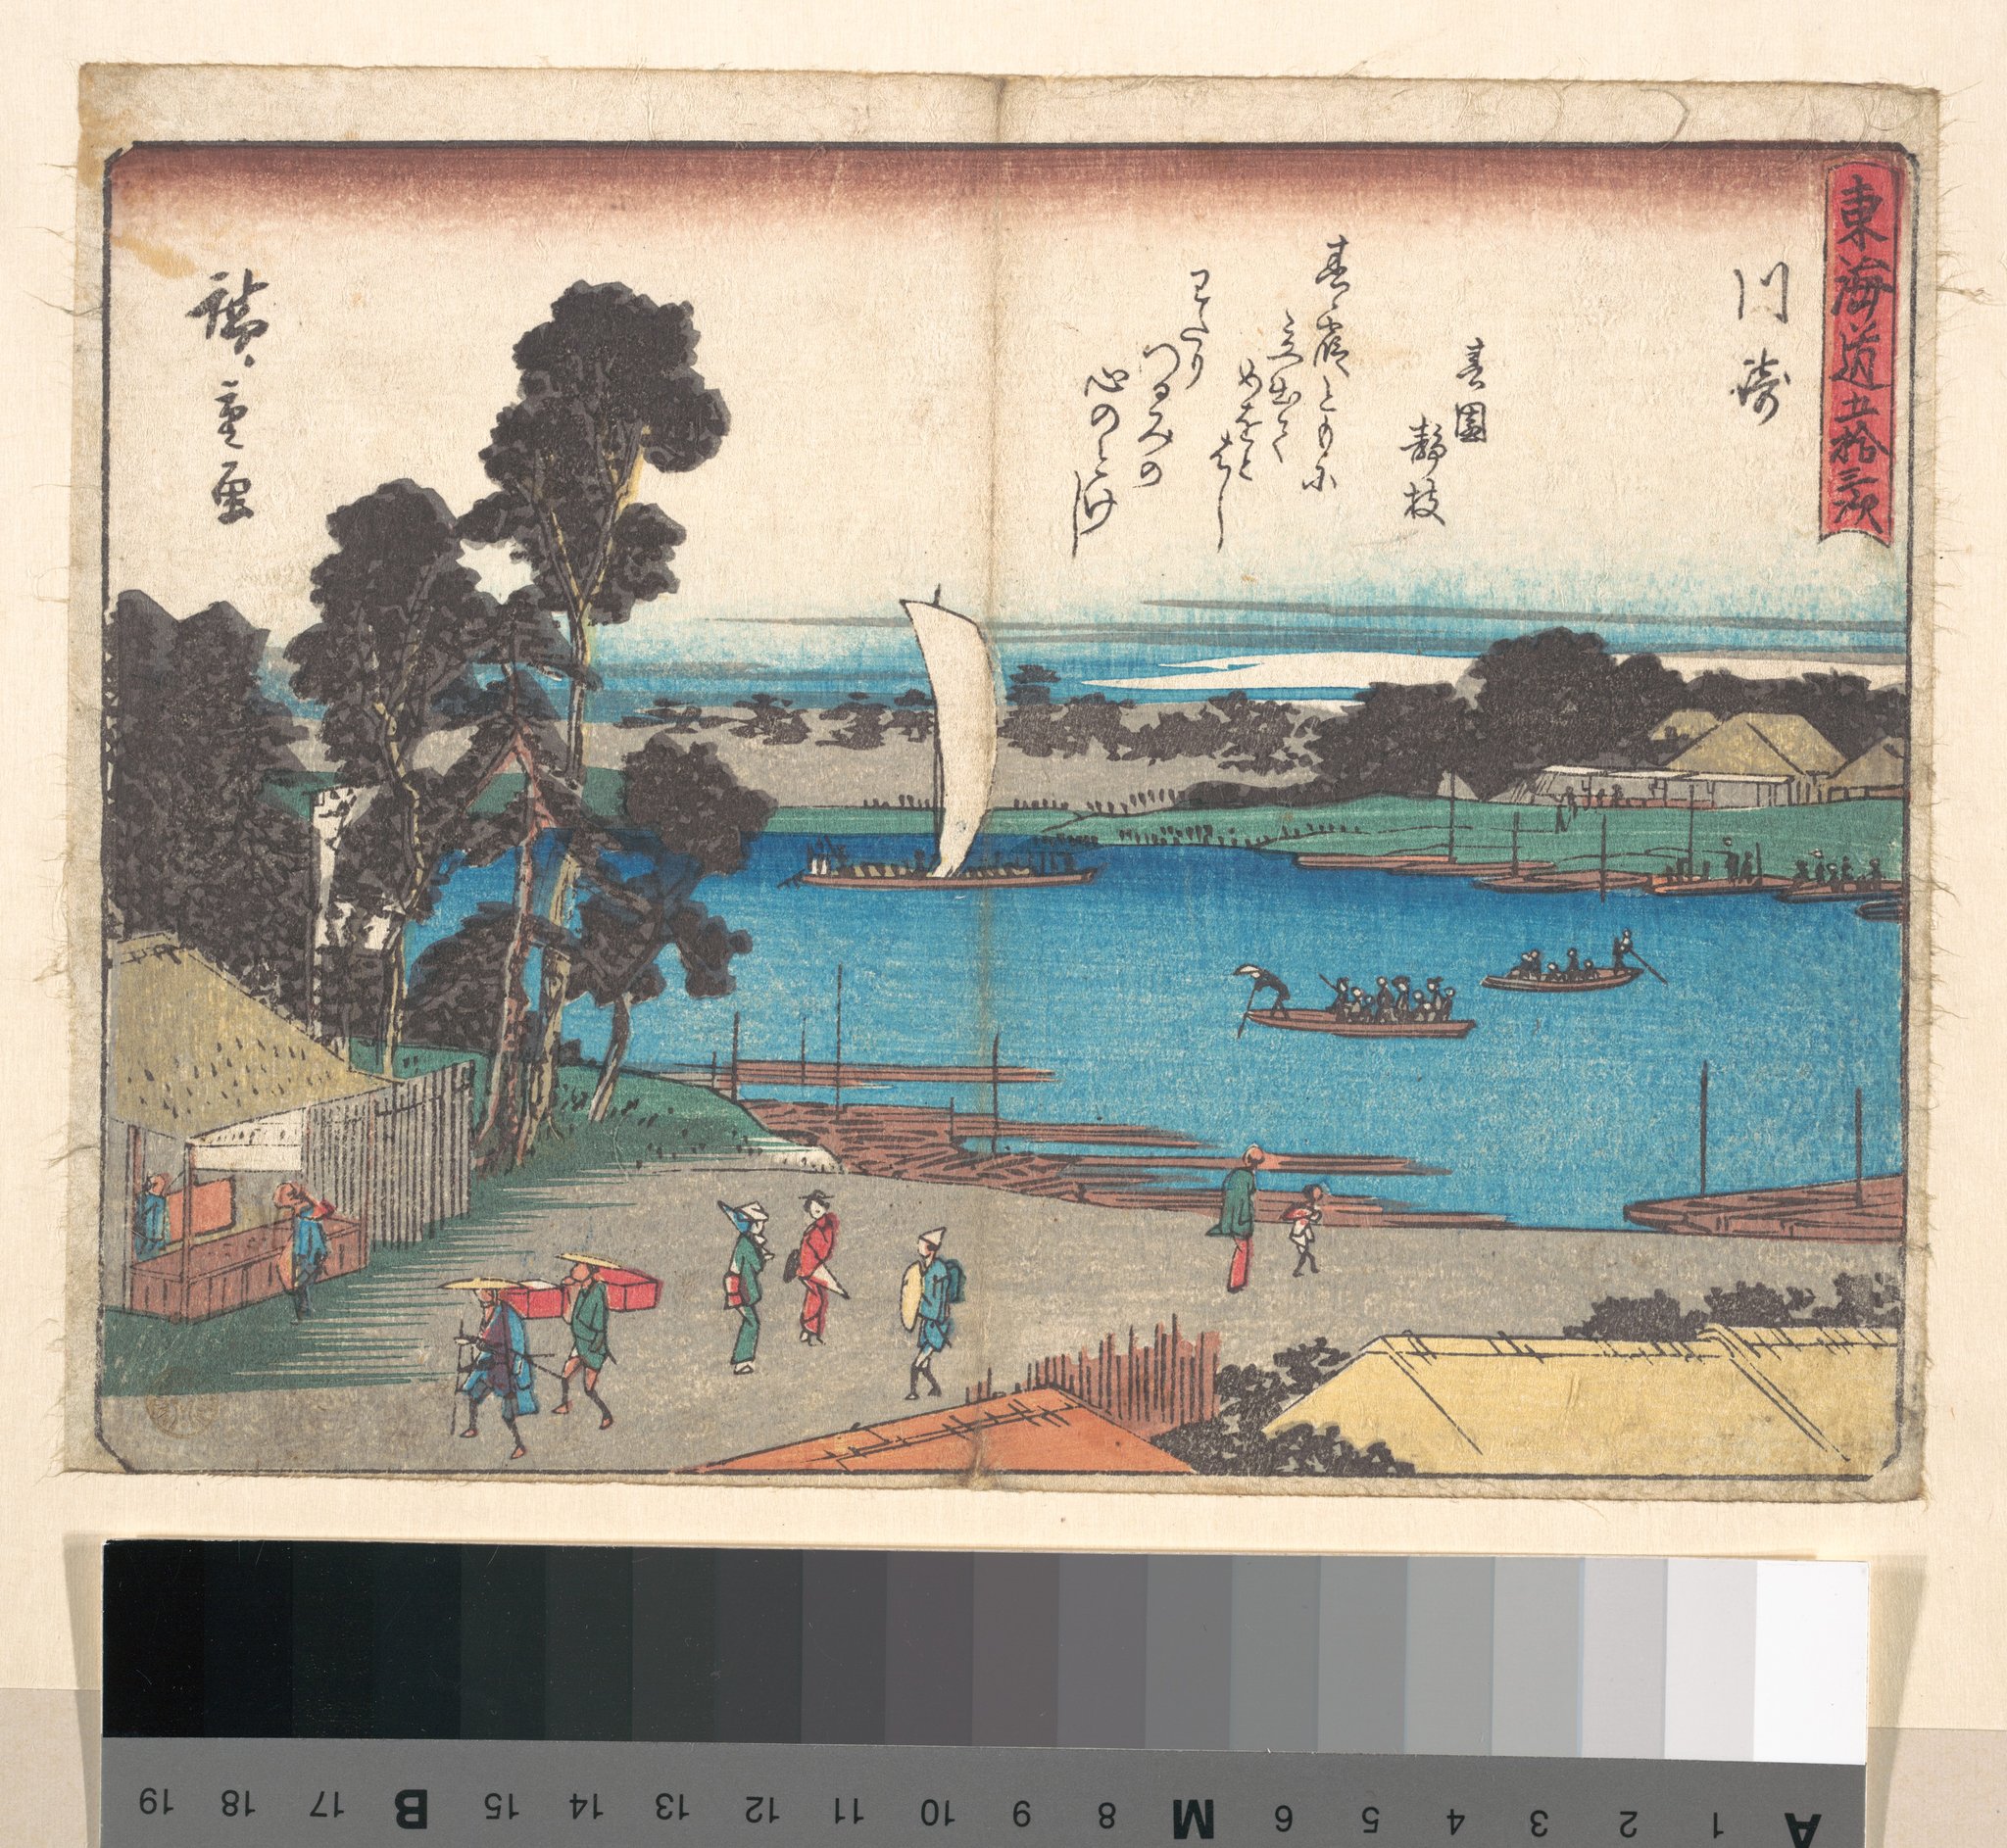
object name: print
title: Kawasaki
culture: japanese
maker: utagawa hiroshige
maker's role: artist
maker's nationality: japanese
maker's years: 1797-1858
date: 1838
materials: ink, paper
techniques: woodblock print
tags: trees,boats